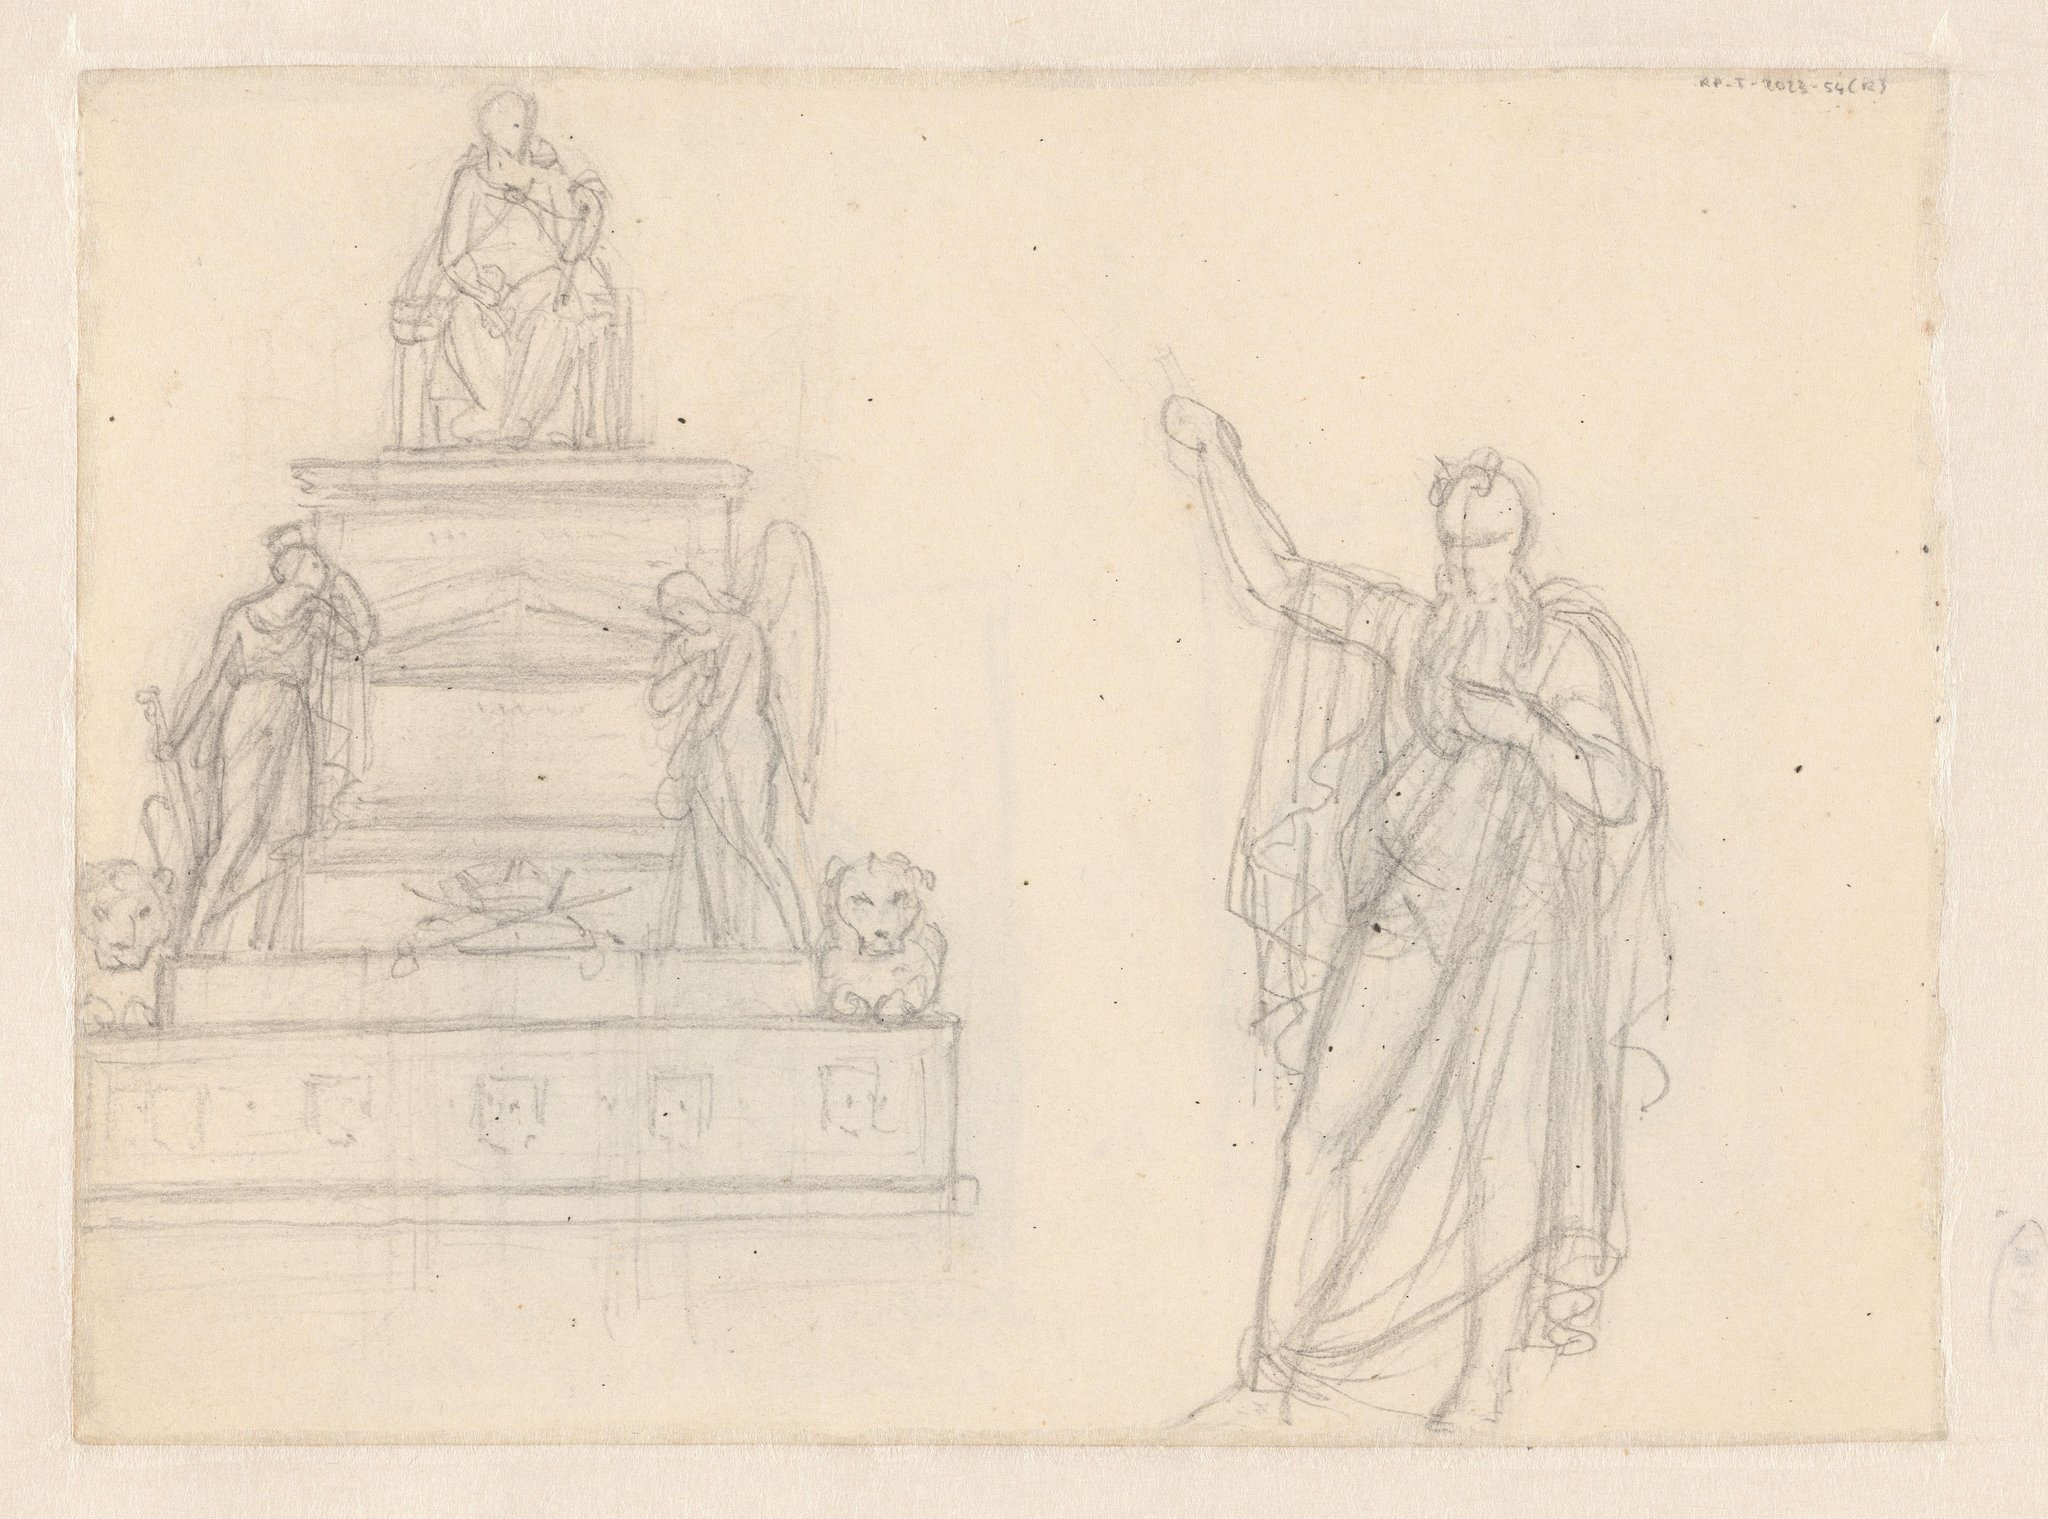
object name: drawing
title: Ontwerp voor een grafmonument en een vrijstaand beeld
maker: louis royer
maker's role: draughtsman, sculptor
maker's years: 1793-1868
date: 1831-1868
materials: paper, pencil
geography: netherlands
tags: monument, statue, epitaph